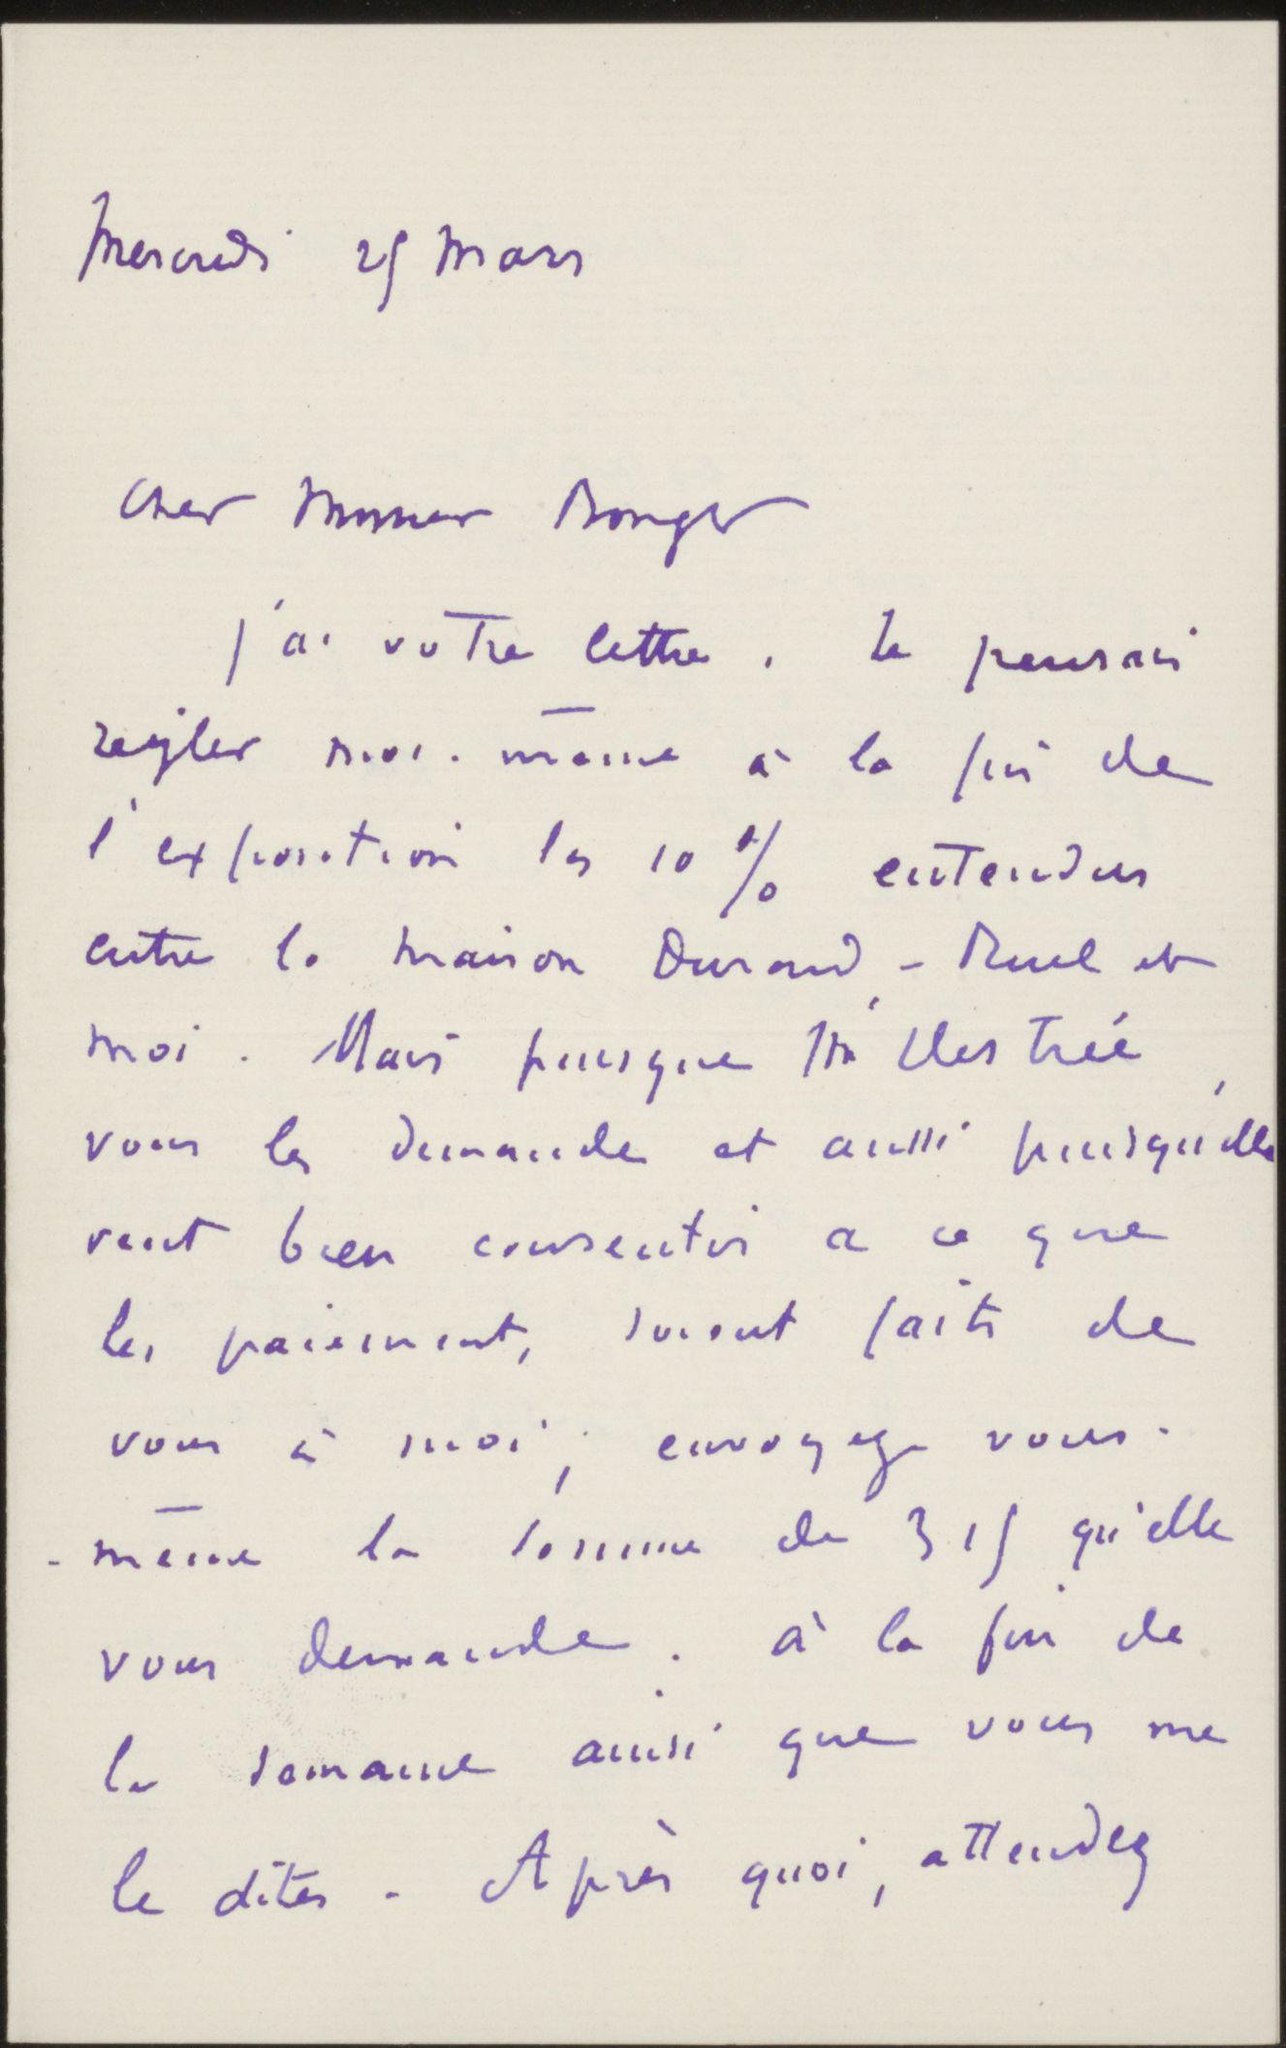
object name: letter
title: Brief aan Andries Bonger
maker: odilon redon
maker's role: draughtsman, painter, print maker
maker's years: 1840-1916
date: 1903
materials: ink, paper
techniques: pen, writing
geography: paris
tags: amsterdam, andries bonger, exhibition ~ art, money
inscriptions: watermark